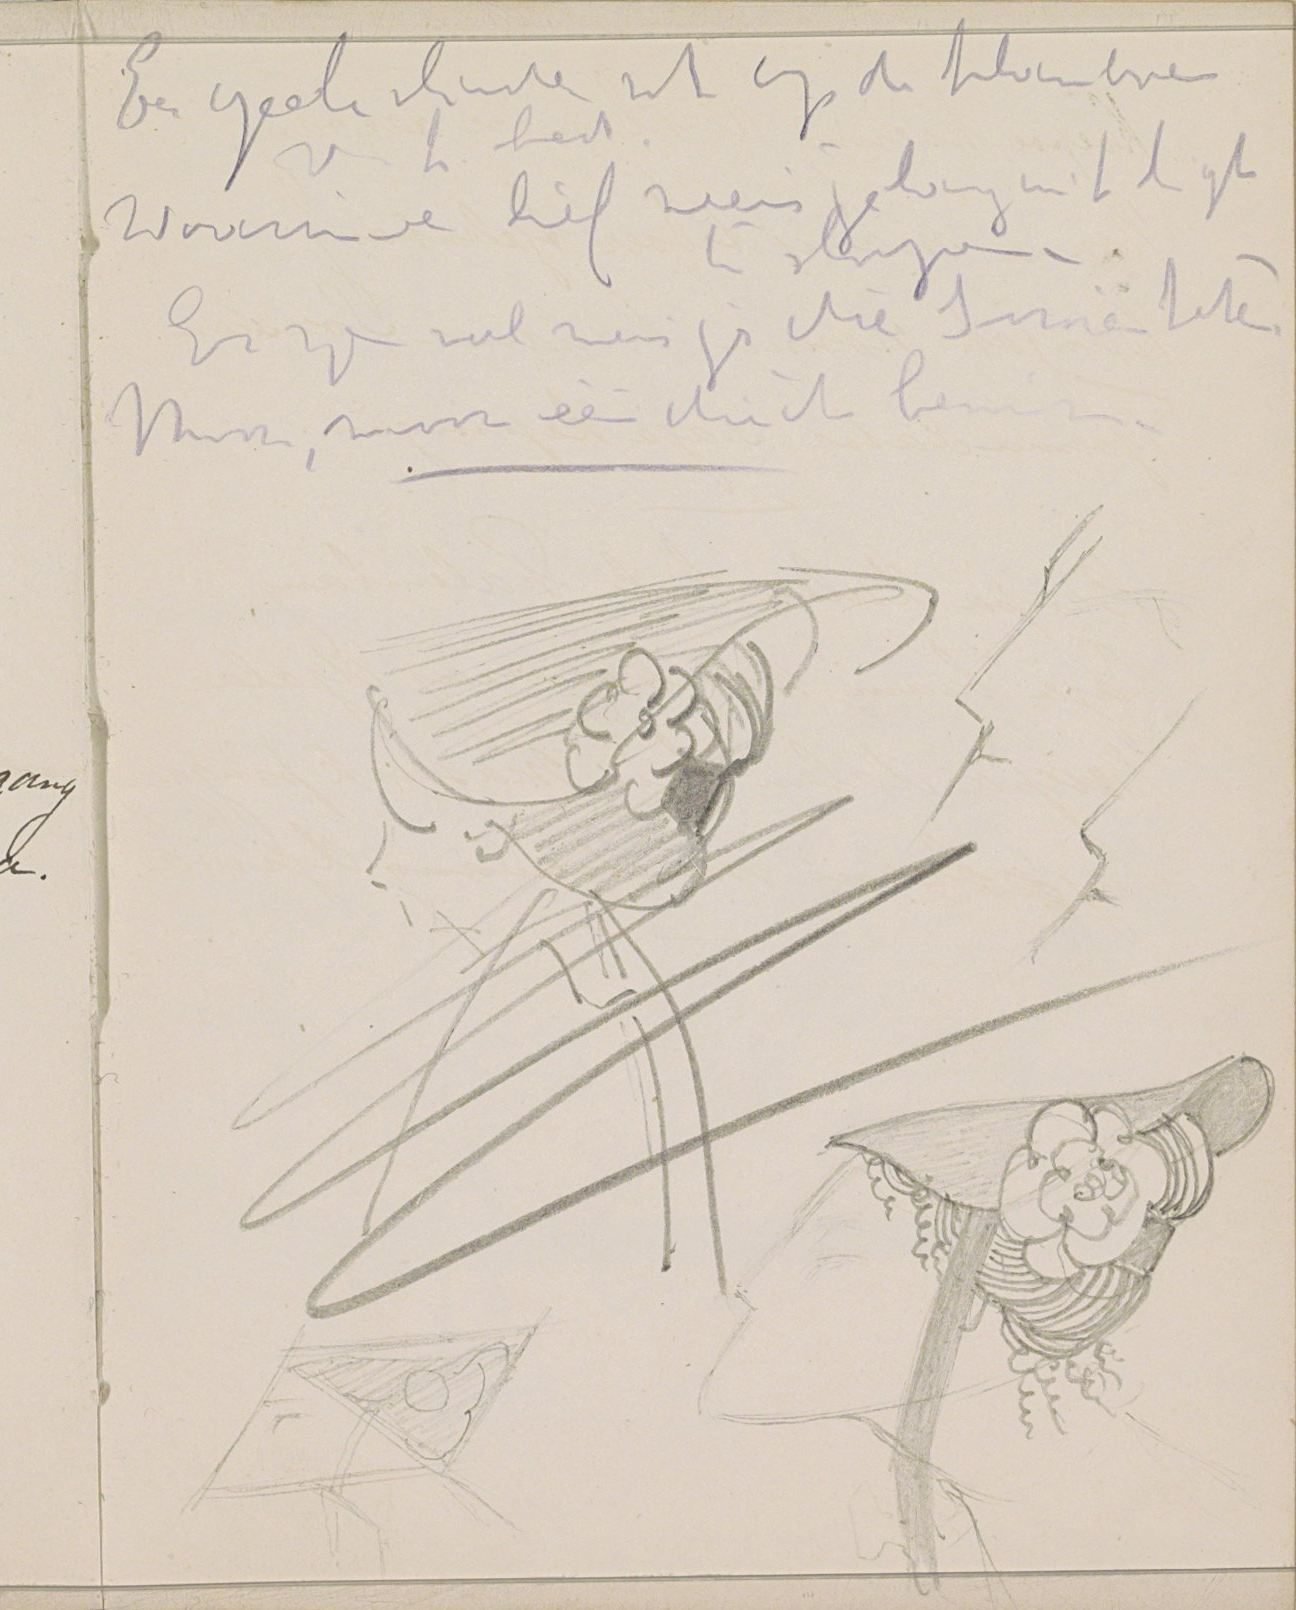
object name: sketchbook leaf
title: Vrouwen met hoofddeksels met bloemen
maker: reijer stolk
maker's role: draughtsman, print maker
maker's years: 1896-1945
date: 1916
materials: paper, pencil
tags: flowers, head (human), head-gear: hat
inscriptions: annotation: ‘Een geele vlinder zit op de klamboe/ [...]’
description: Blad 13 recto uit een schetsboek met 72 bladen.